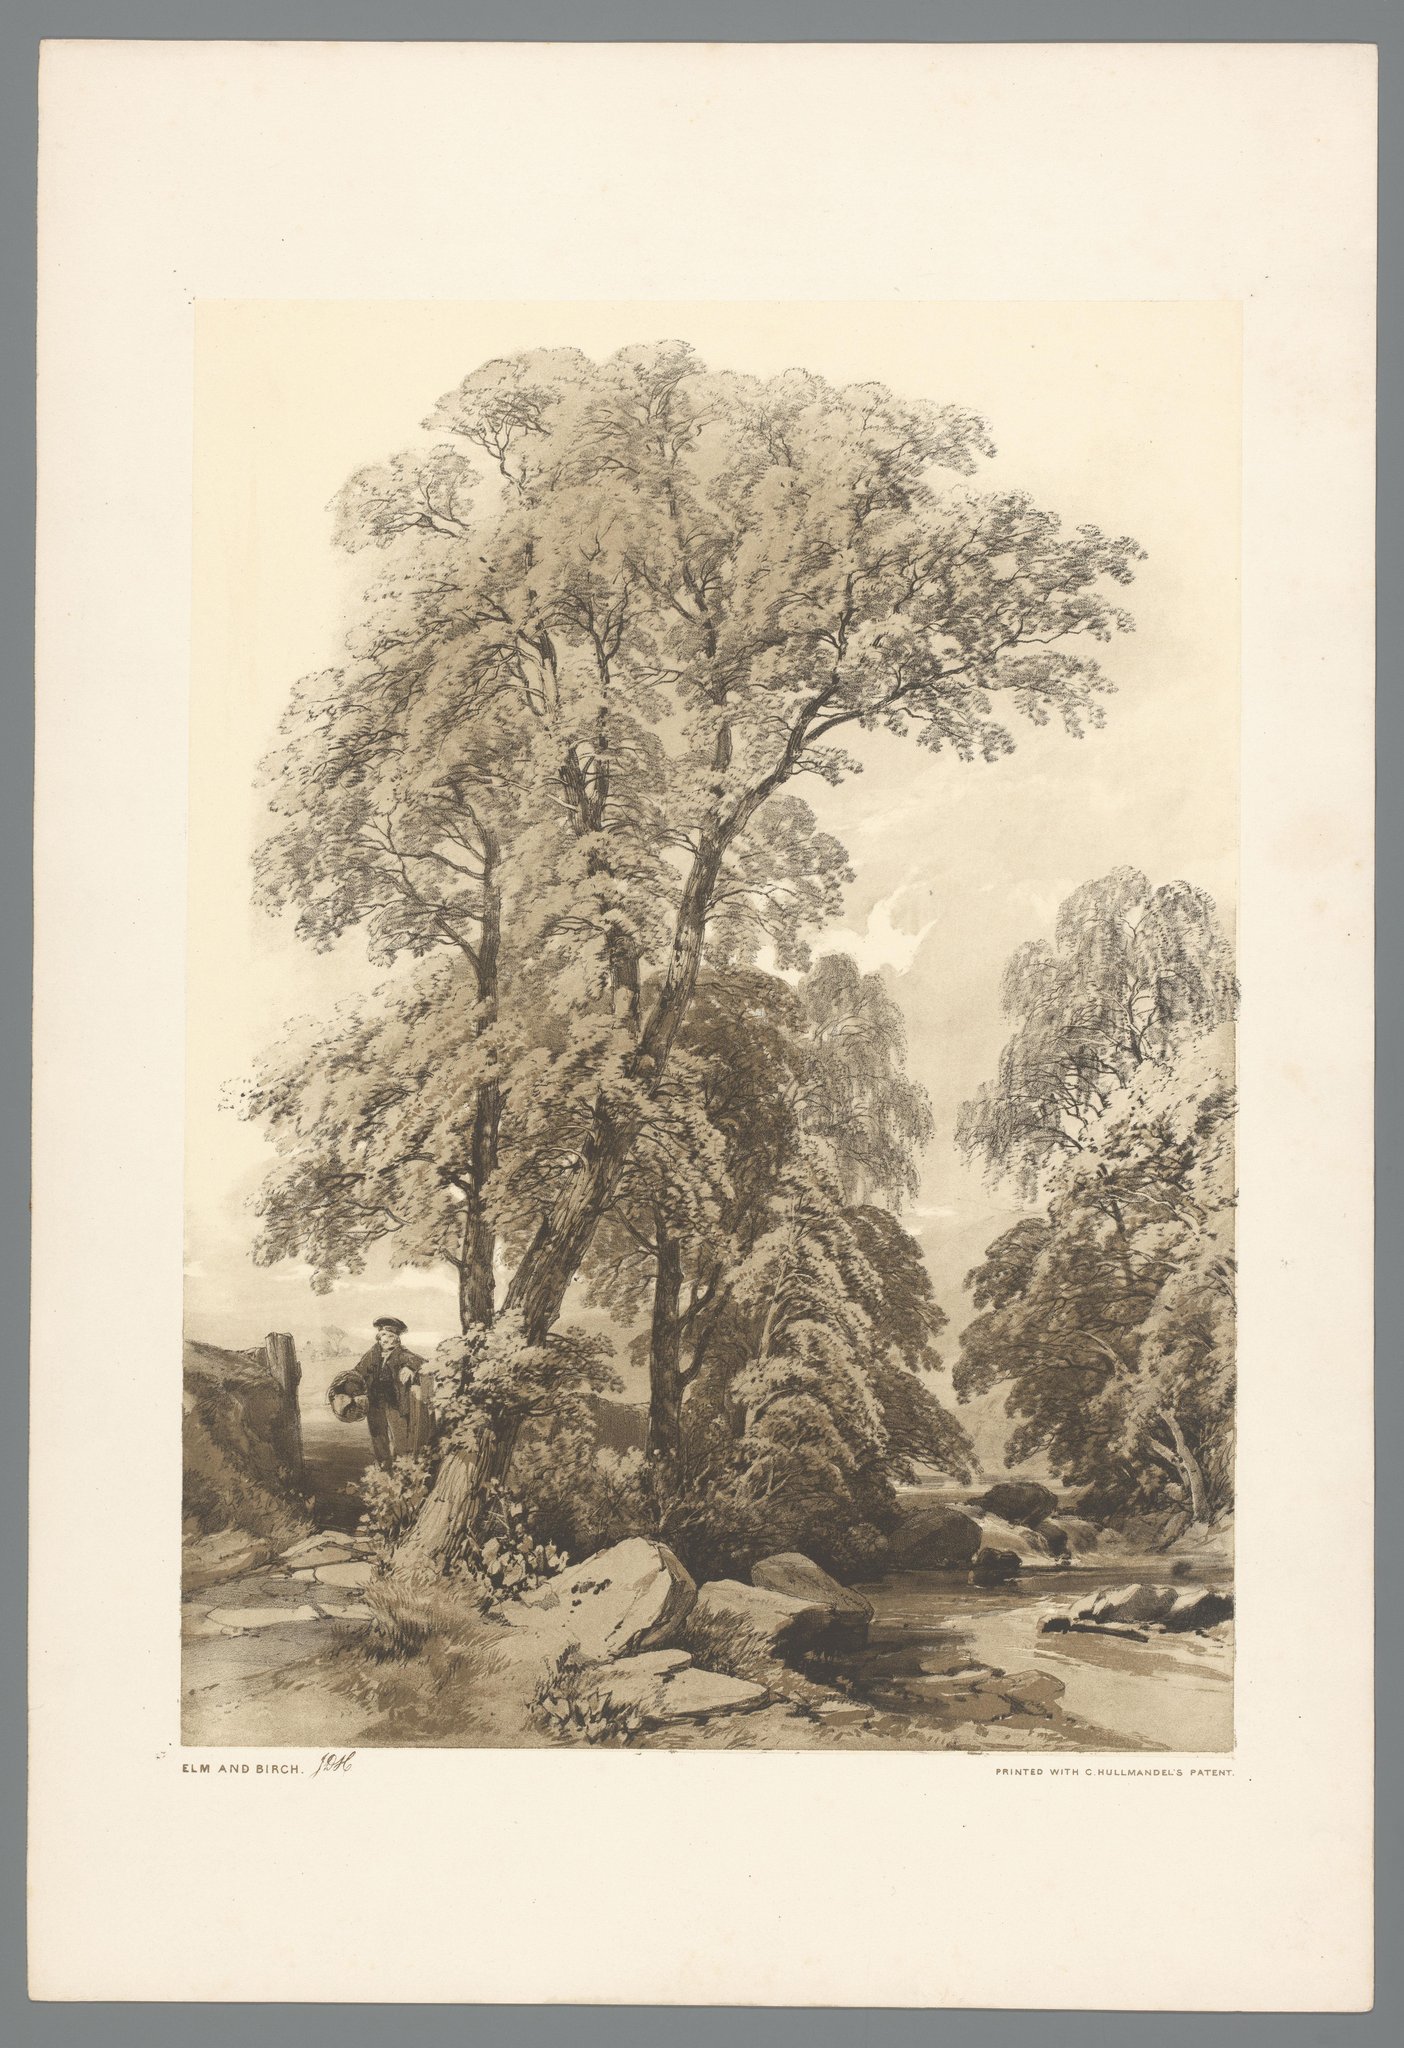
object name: print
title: Landschap met bomen aan een oever nabij Leatherhead en Dorking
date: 1841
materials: paper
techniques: tone lithography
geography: london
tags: park, river bank, forest, wood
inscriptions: collector's mark: Lugt 2760, collector's mark: Lugt 2228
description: Prent maakt deel uit van een serie van 24 prenten.